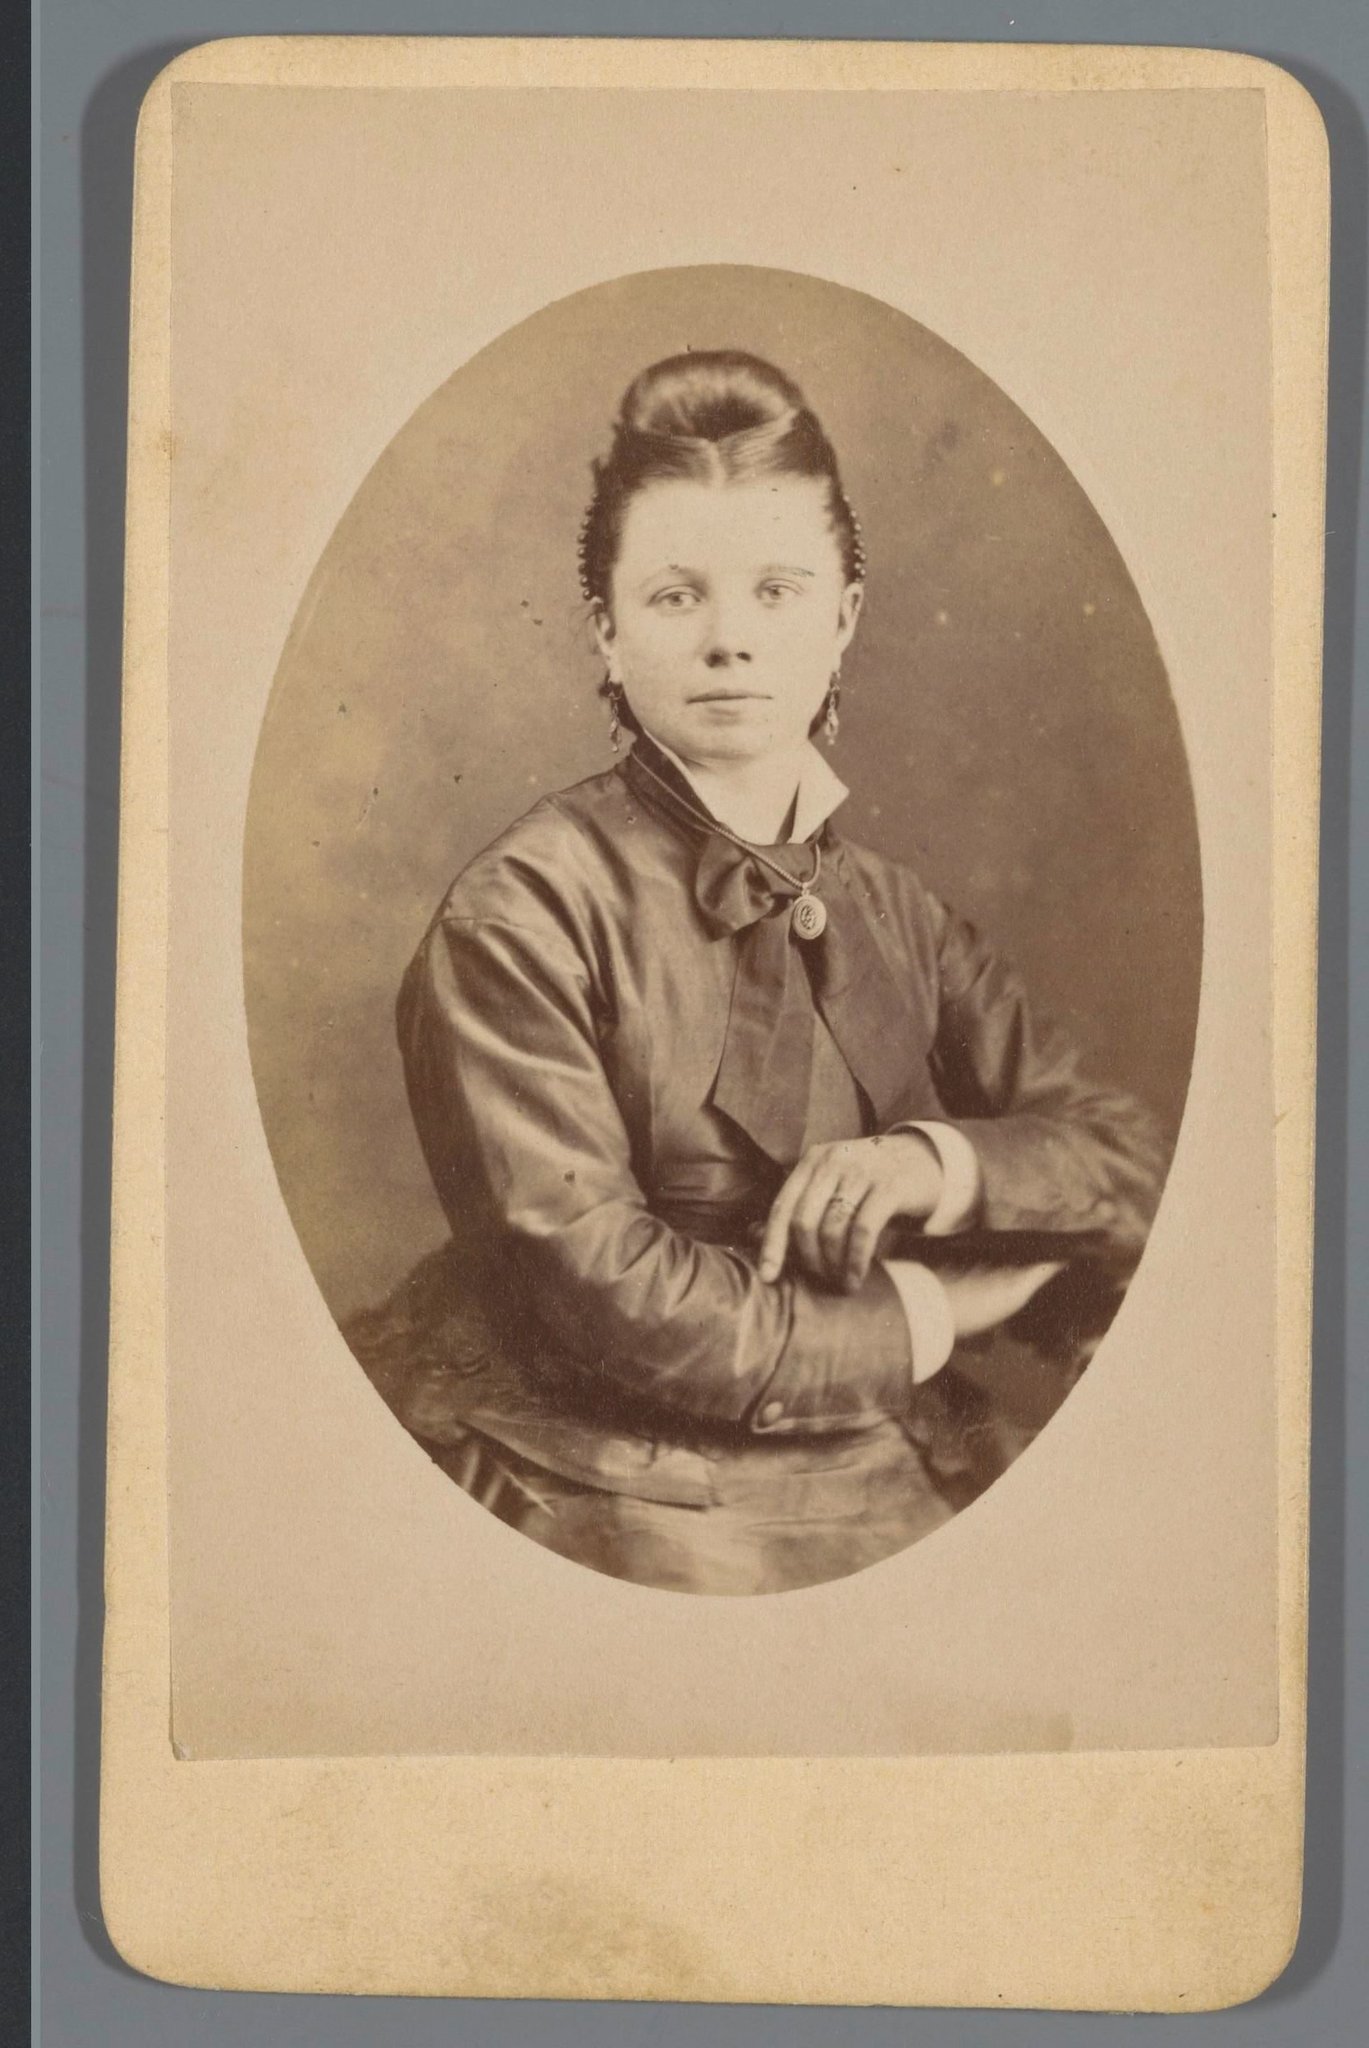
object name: photograph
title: Portret van een onbekende jonge vrouw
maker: coenraad cornelis roskam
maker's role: fotograaf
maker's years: 1829-1892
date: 1870-1881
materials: cardboard, paper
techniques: albumen print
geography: amsterdam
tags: adolescent, young woman, maiden, anonymous historical person portrayed, amsterdam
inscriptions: inscription: ‘Photogr. Atelier/ C.C. Roskam/ Utrechtsestraat/ tusschen de Keizersgracht en Kerkstraat/ Z.60./ Amsterdam.’